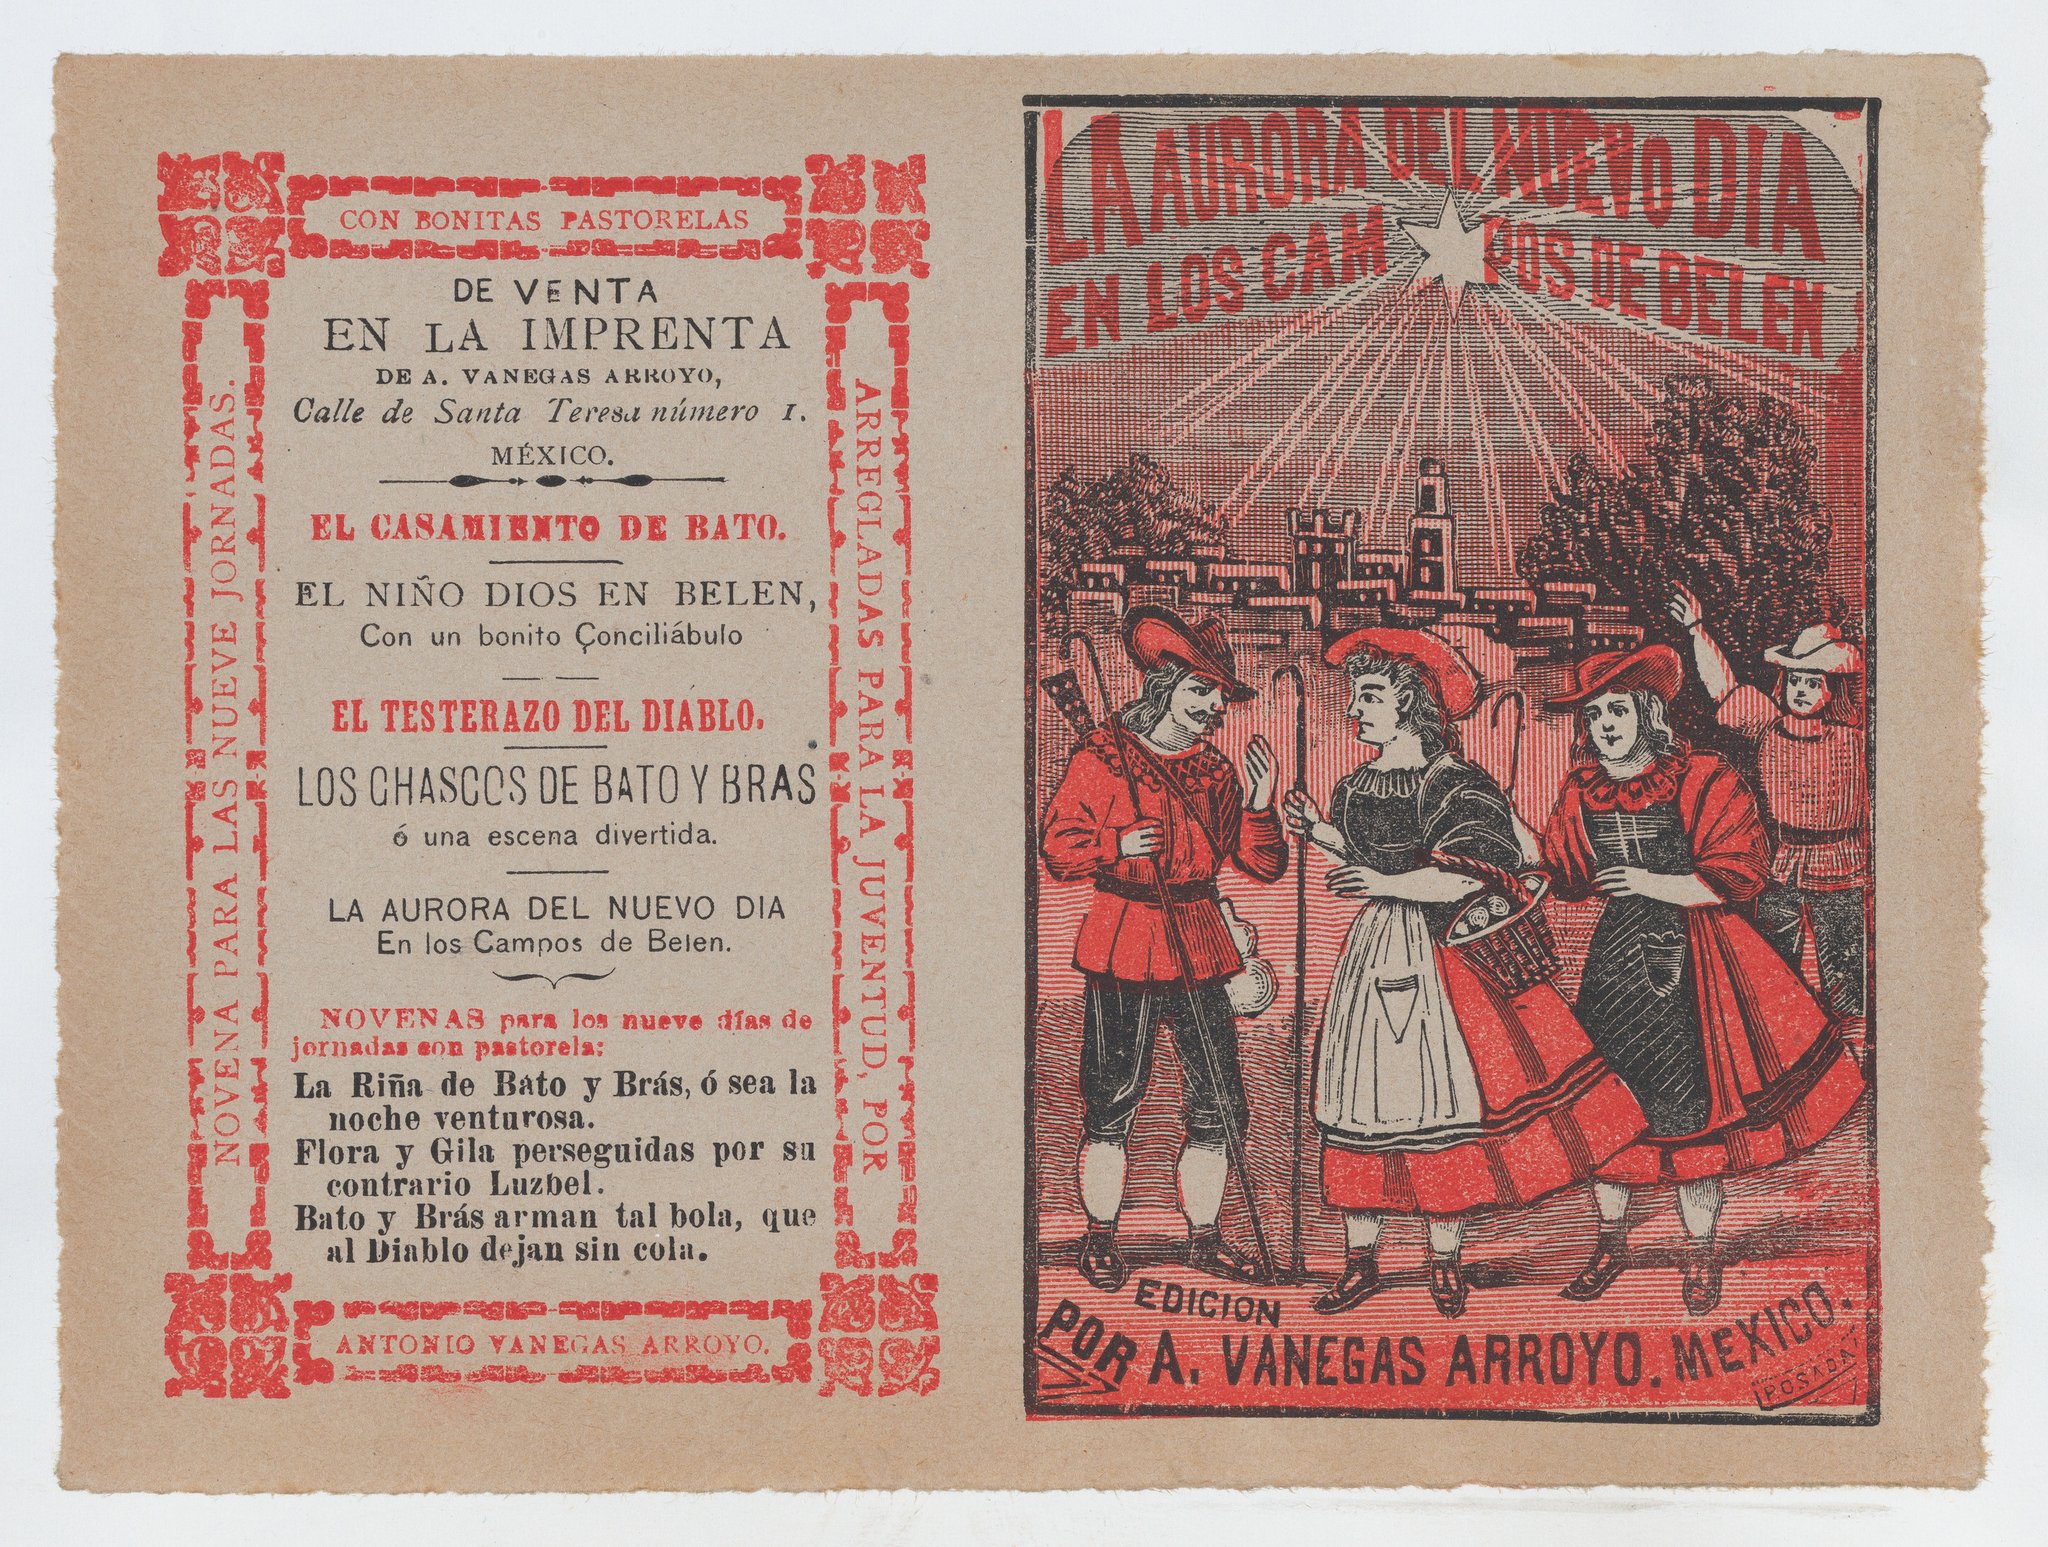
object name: print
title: Cover for 'La Aurora del Nuevo Dia en los Campos de Belen', villagers holding shepherd's hooks and walking in the countryside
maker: josé guadalupe posada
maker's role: artist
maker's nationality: mexican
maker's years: 1852-1913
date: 1891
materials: ink, metal, paper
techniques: engraving, letterpress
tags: men,women